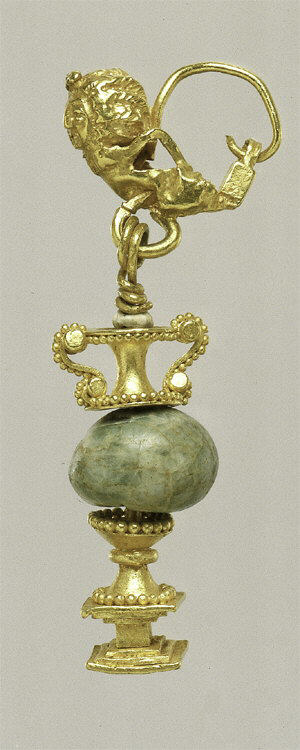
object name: earring with eros and vase pendant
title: Gold and beryl earring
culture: cypriot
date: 200-1 BCE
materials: gold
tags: eros